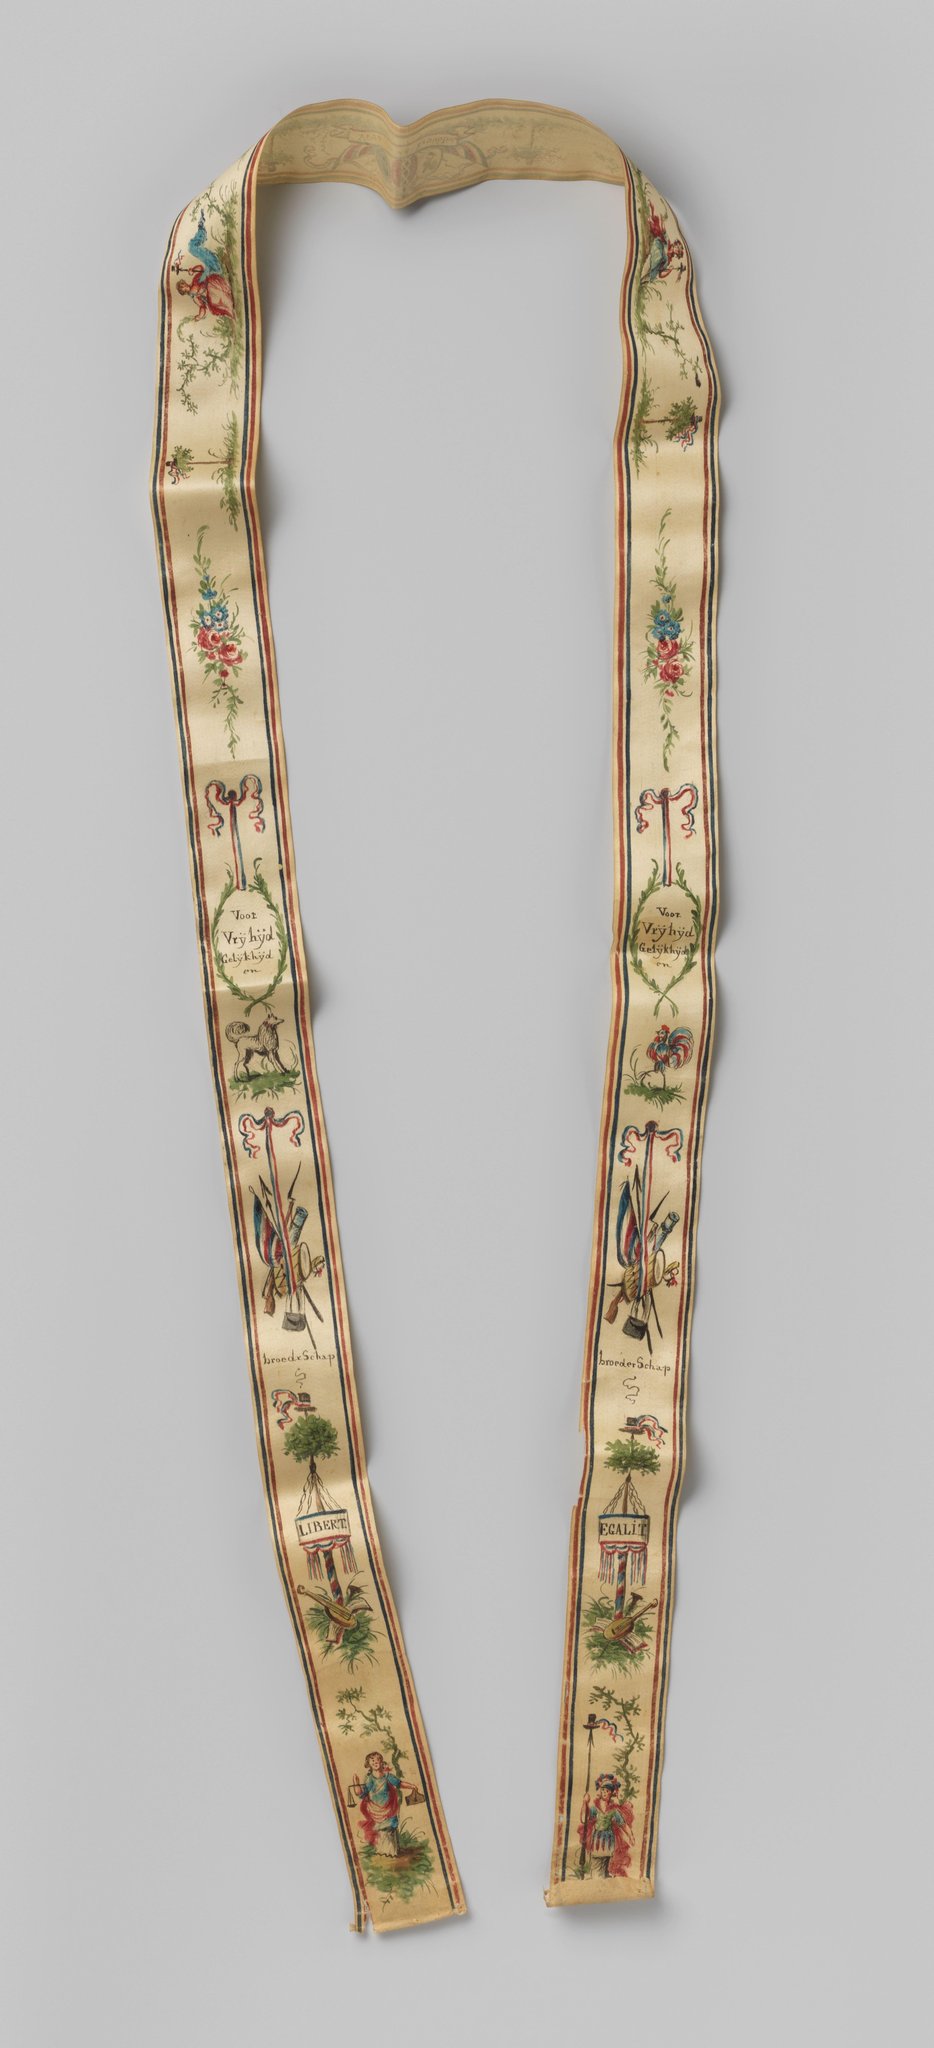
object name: ribbon material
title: Patriottenlint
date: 1775-1800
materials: silk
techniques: painted, weave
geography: amsterdam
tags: amsterdam